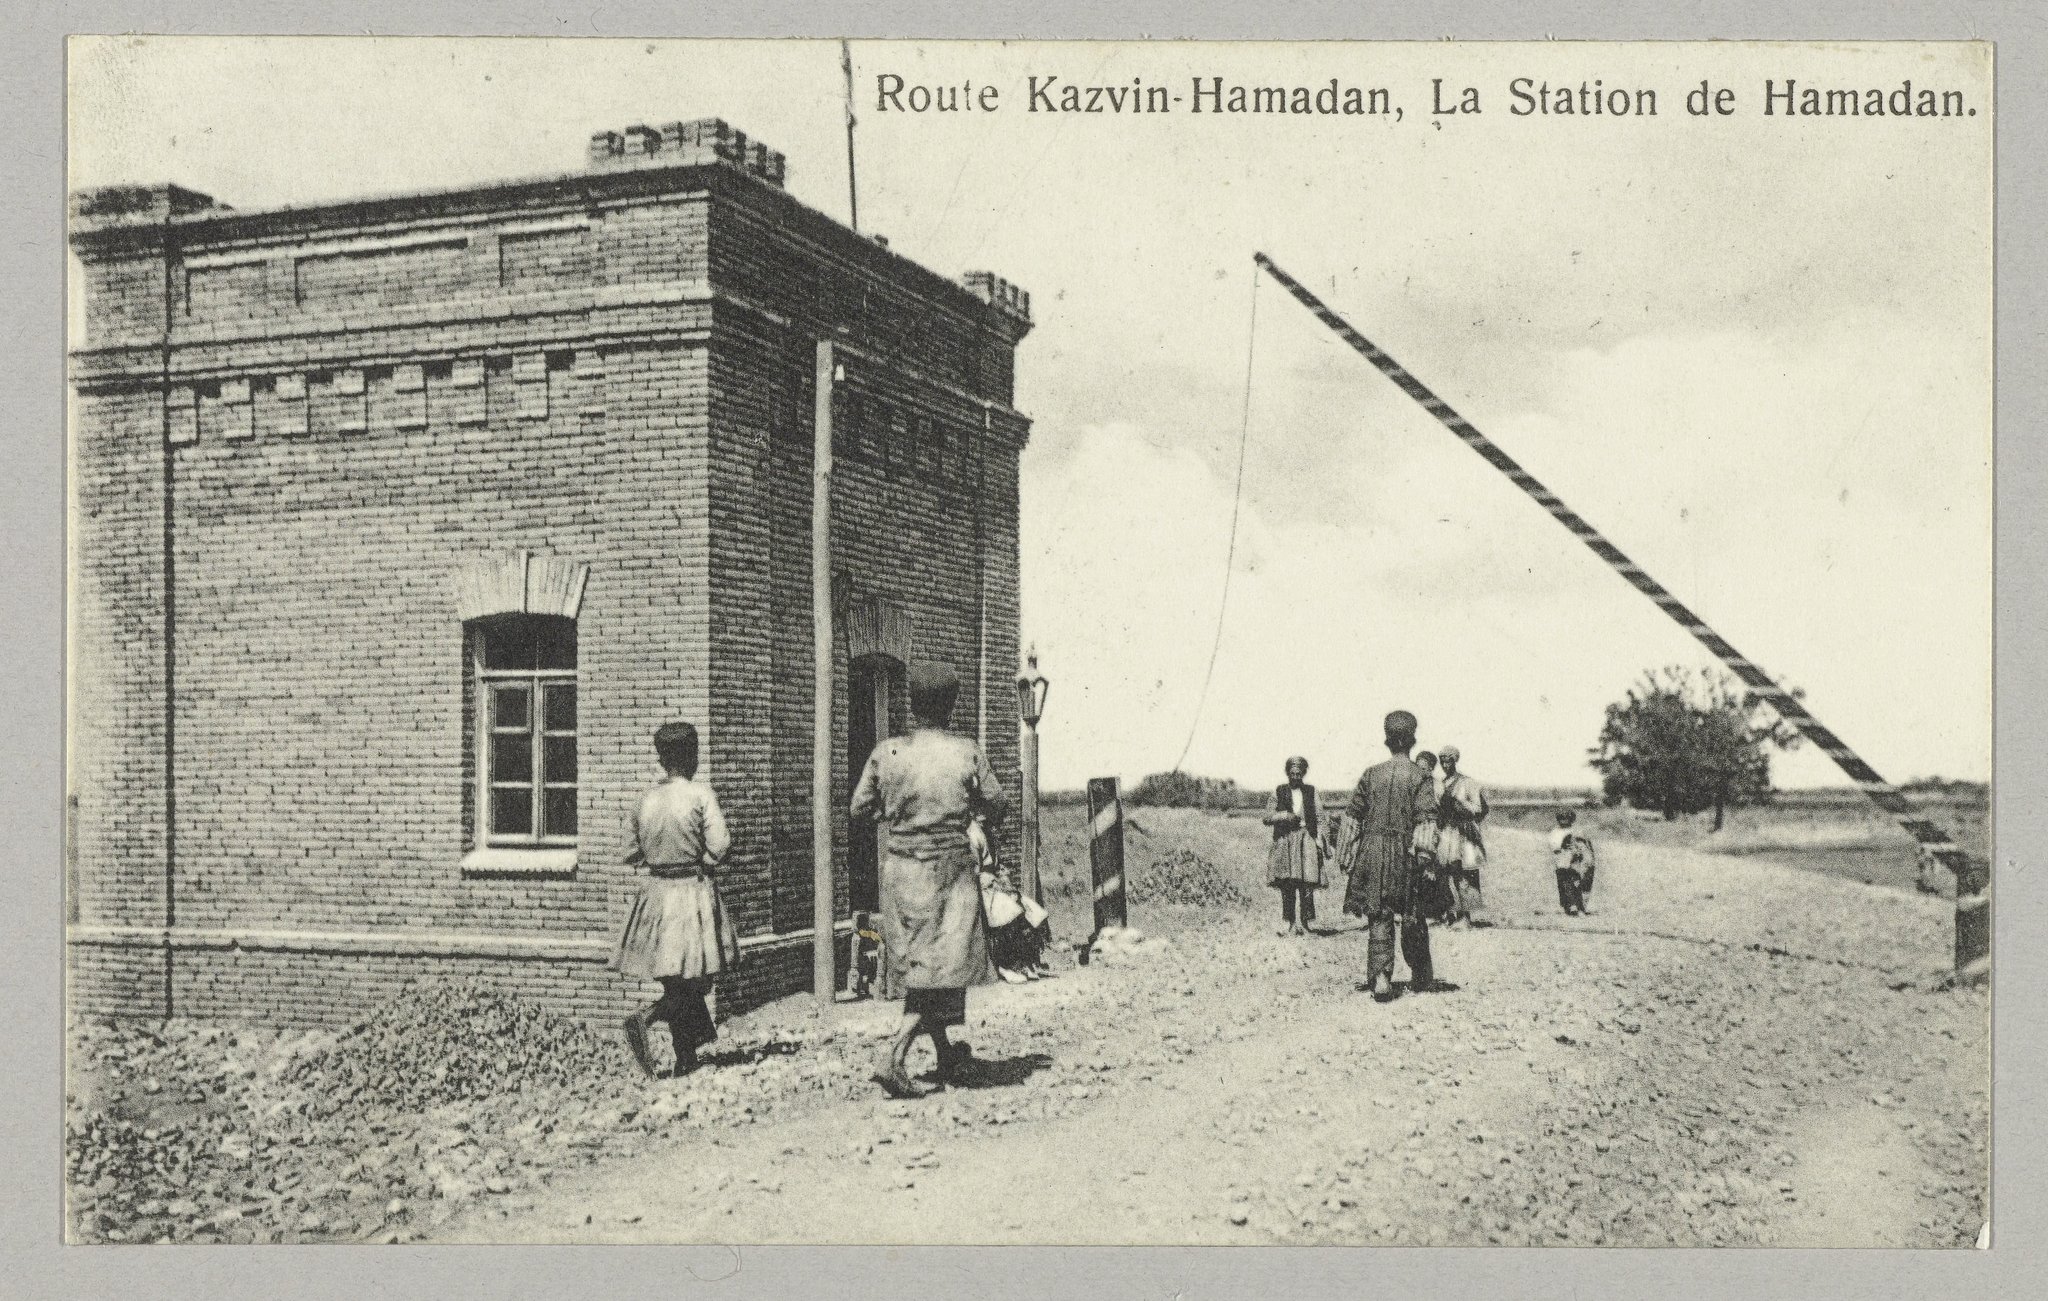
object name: photomechanical print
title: Route Kazvin-Hamadan, La Station de Hamadan.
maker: Anonymous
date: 1895-1915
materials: cardboard, paper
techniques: photograph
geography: hamadan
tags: hamadan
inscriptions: annotation: ‘33. Weg naar Tabris (Perzië)’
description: Grenspost (?) aan de weg van Kazvin naar Hamadan.